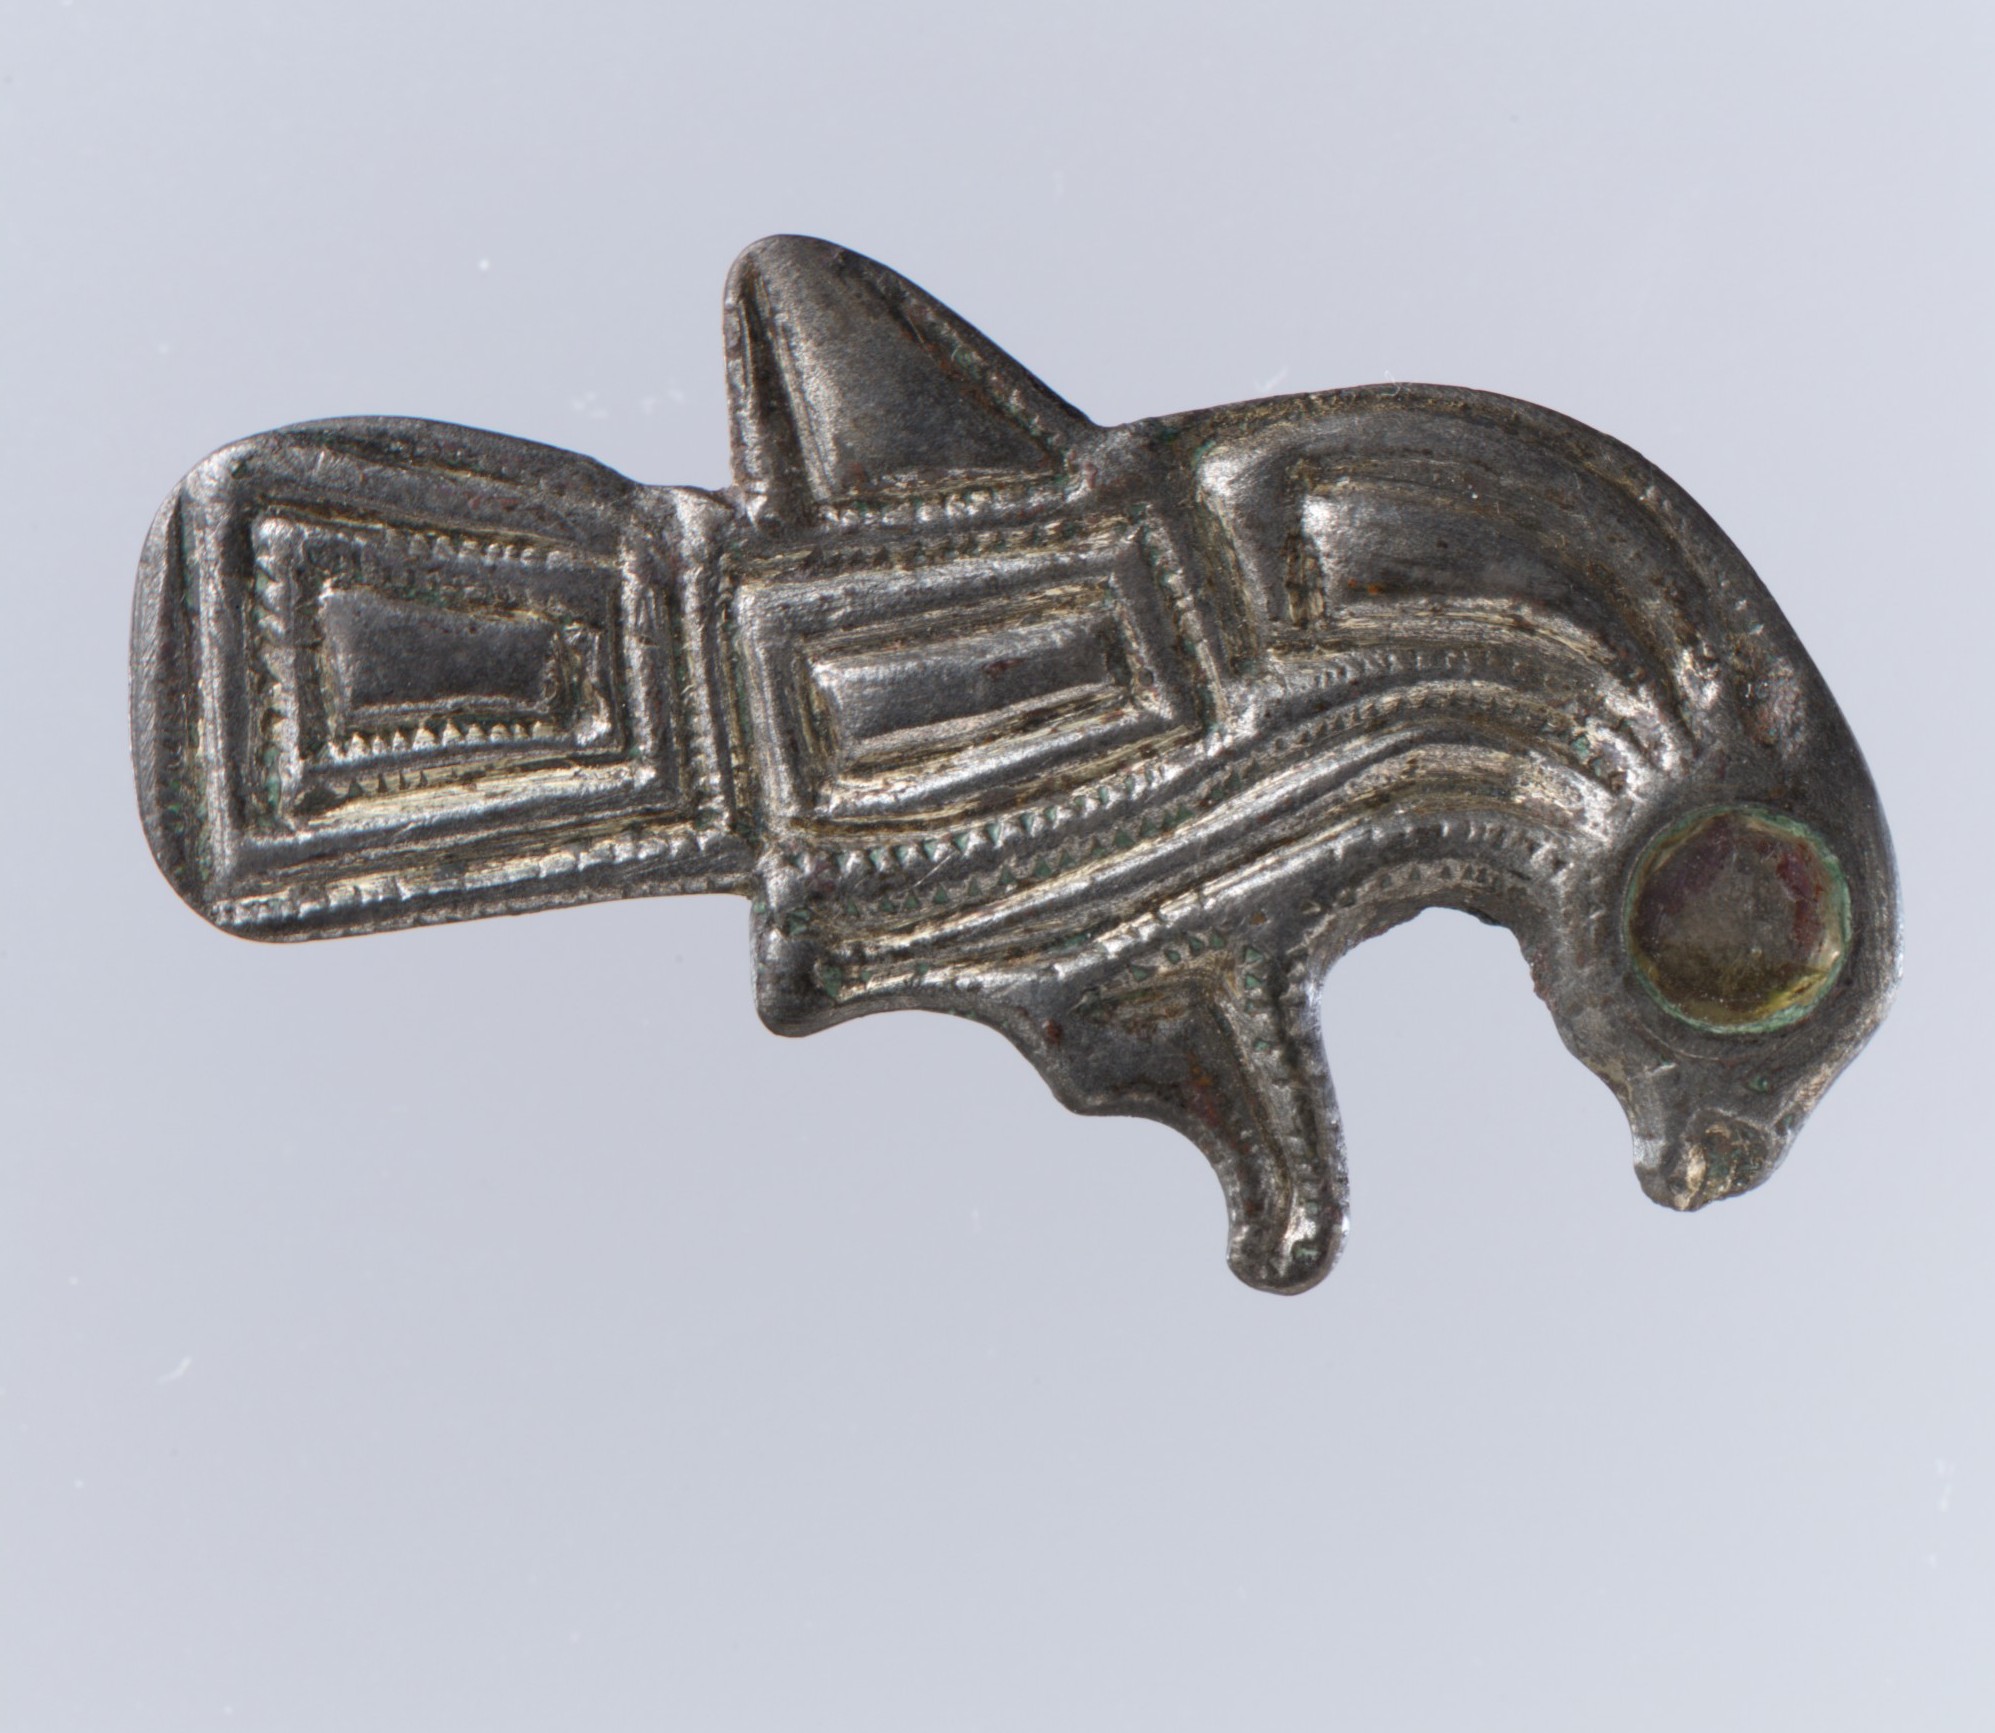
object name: brooch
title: Bird-Shaped Brooch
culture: frankish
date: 551-600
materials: glass, paste, silver gilt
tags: birds